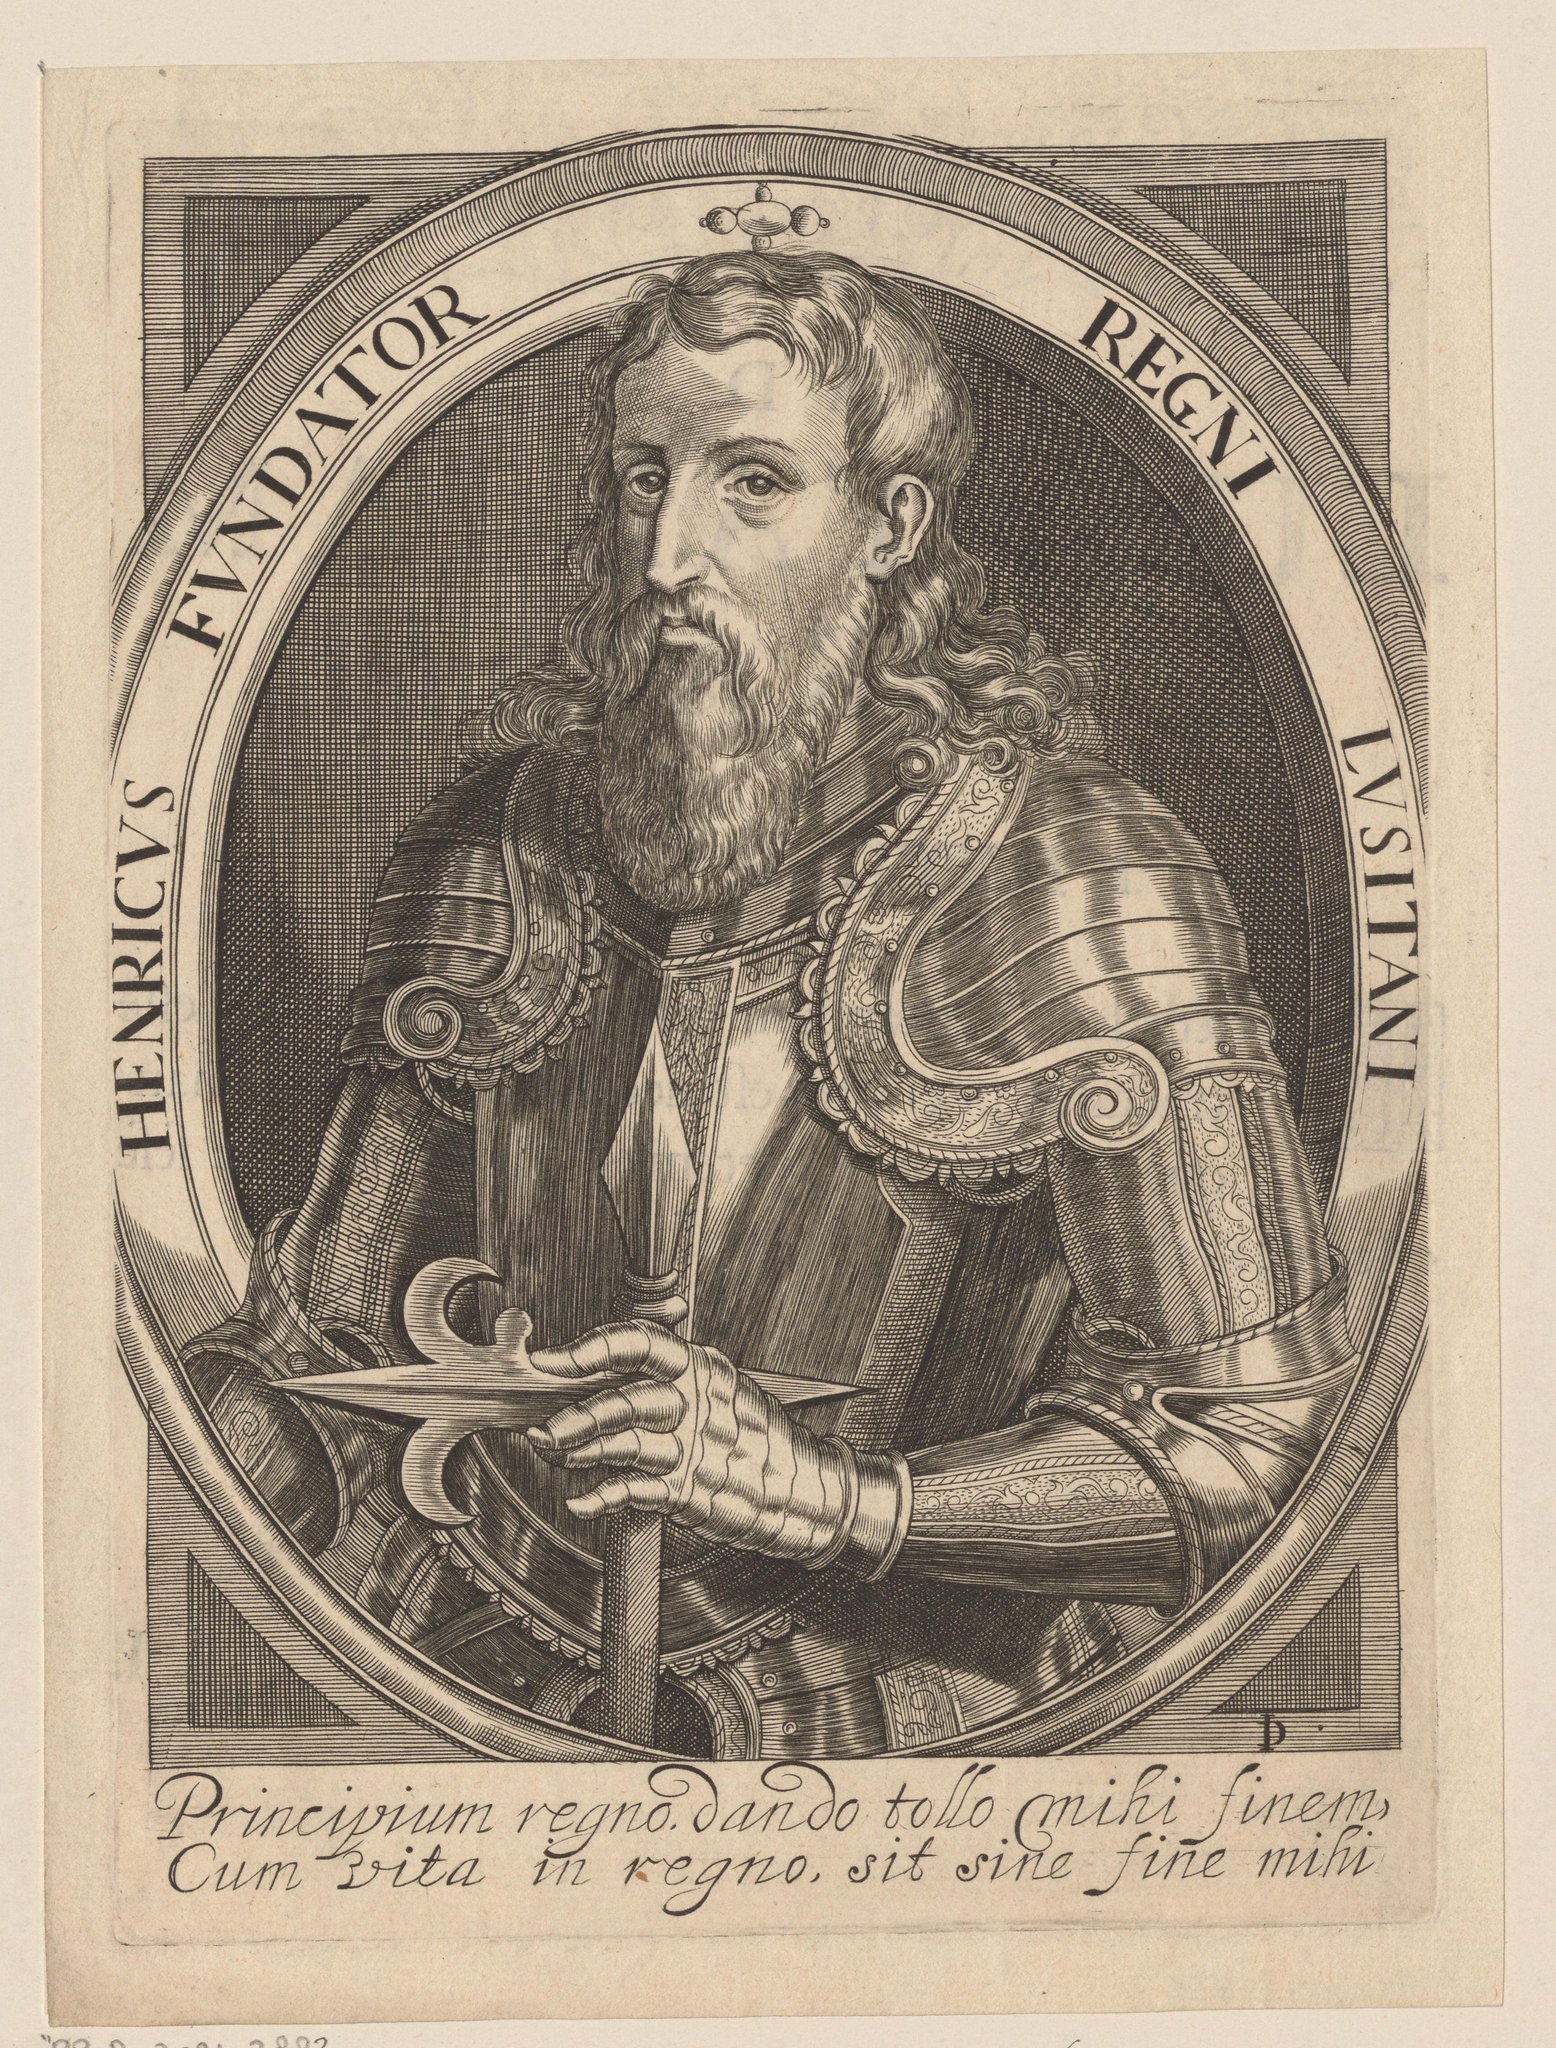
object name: book illustration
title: Portret van Hendrik van Bourgondië, graaf van Portugal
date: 1645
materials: paper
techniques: engraving, letterpress printing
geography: london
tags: earl, armour, historical persons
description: Prent uit: Sousa Macedo, Antonio de. Lusitania liberata ab injusto Castellanorum dominio. Londen: Richard Hearne, 1645.